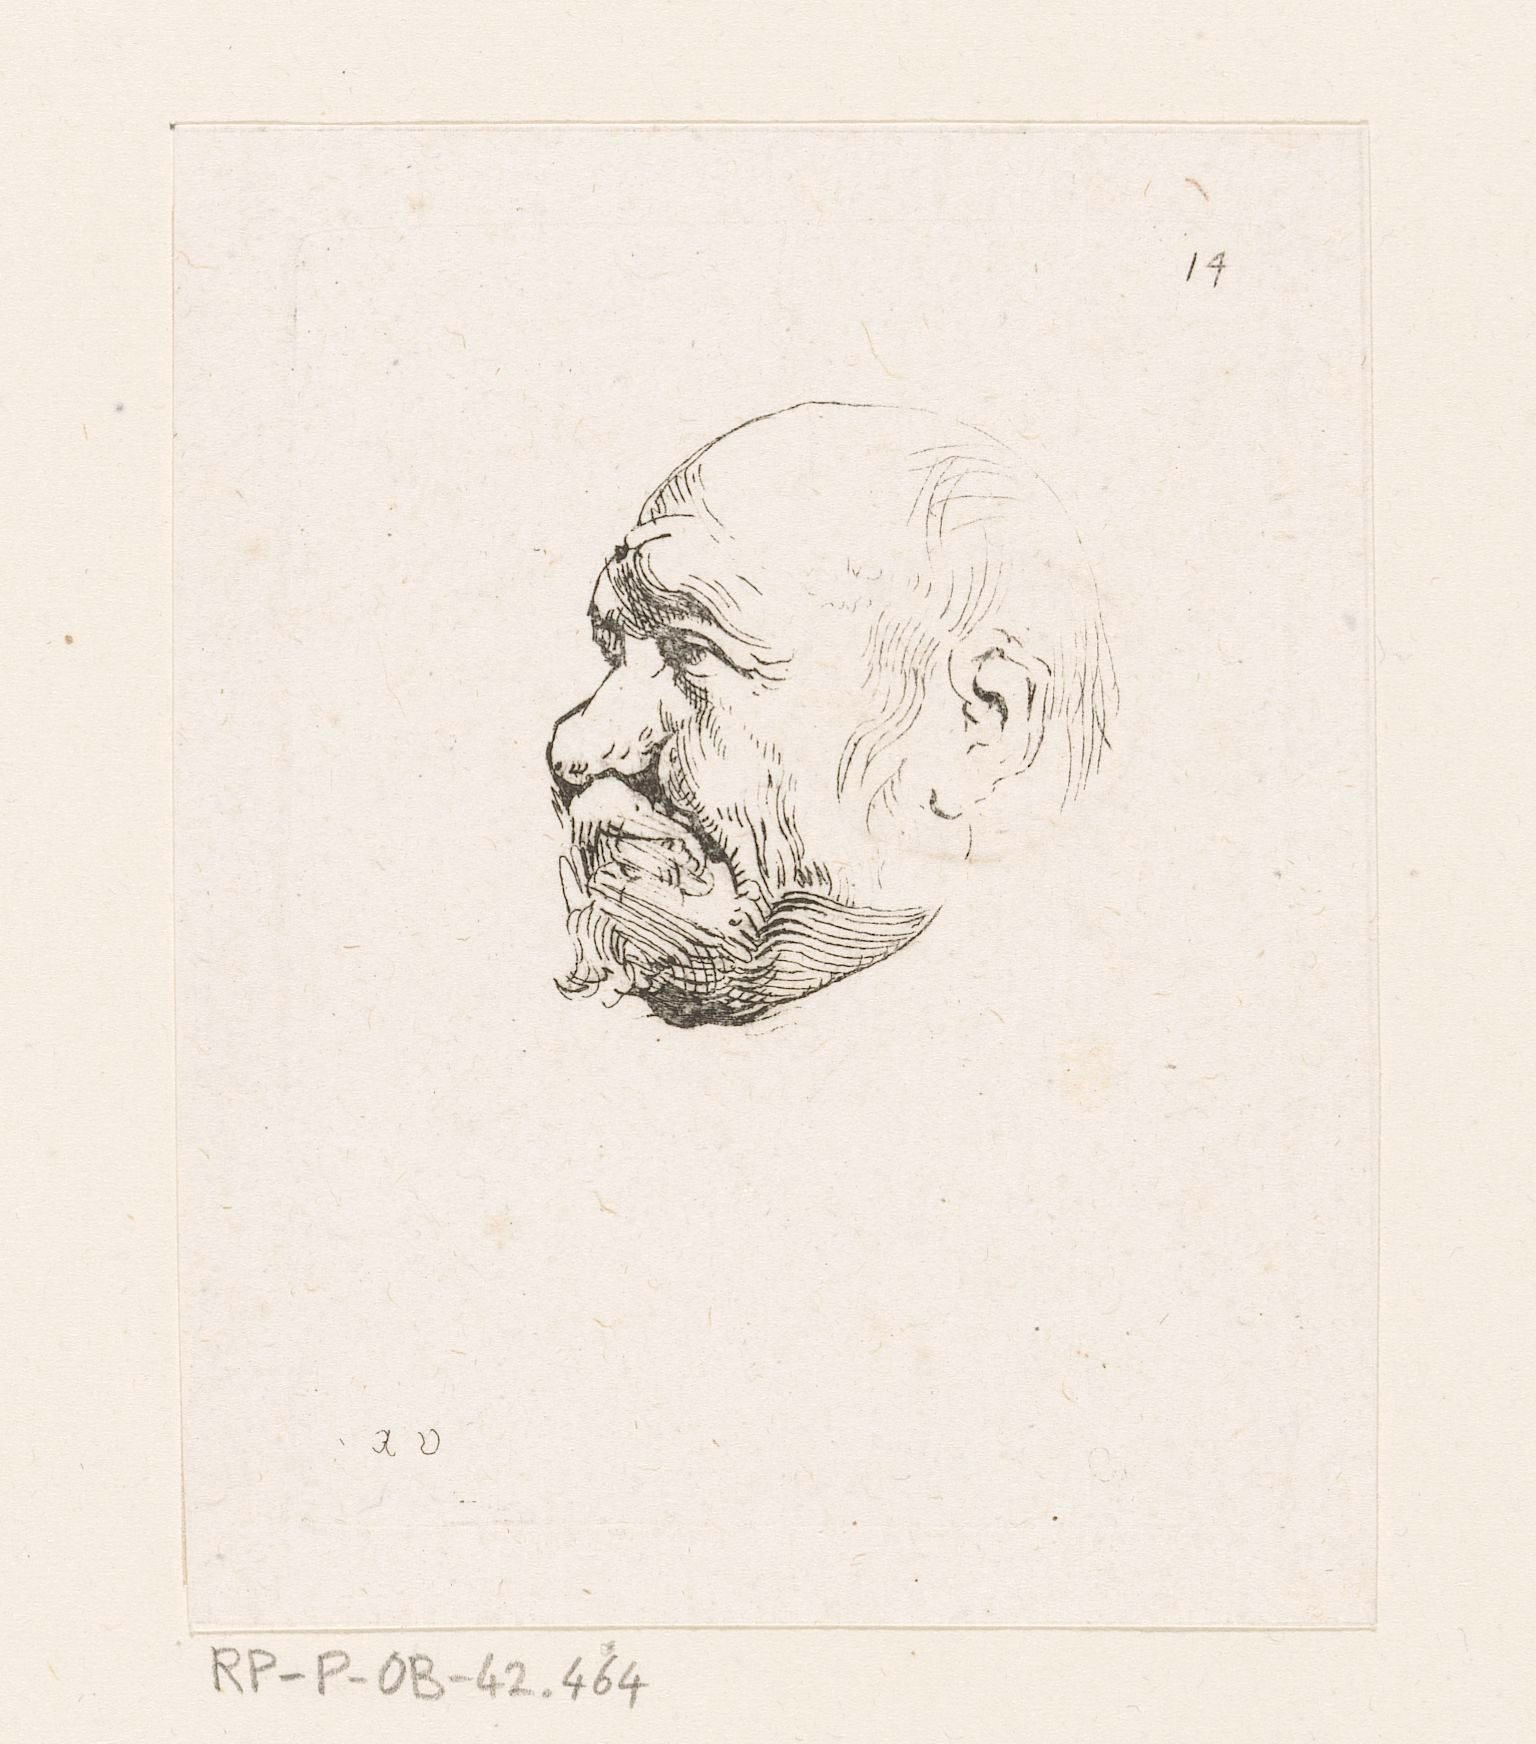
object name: print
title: Recueil de Testes d'Antoine Van Dyck (...)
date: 1735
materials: paper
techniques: etching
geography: france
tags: head (human), adult man, baldness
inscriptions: collector's mark: Lugt 240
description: Prent uit een serie van 31 prenten naar getekende hoofden door Van Dyck, plus een titelprent naar Bouchardon, getiteld: "Recueil de Testes d'Antoine Van Dyck tirées du Cabinet de M. Crozat et gravées par M. le C. de C.".